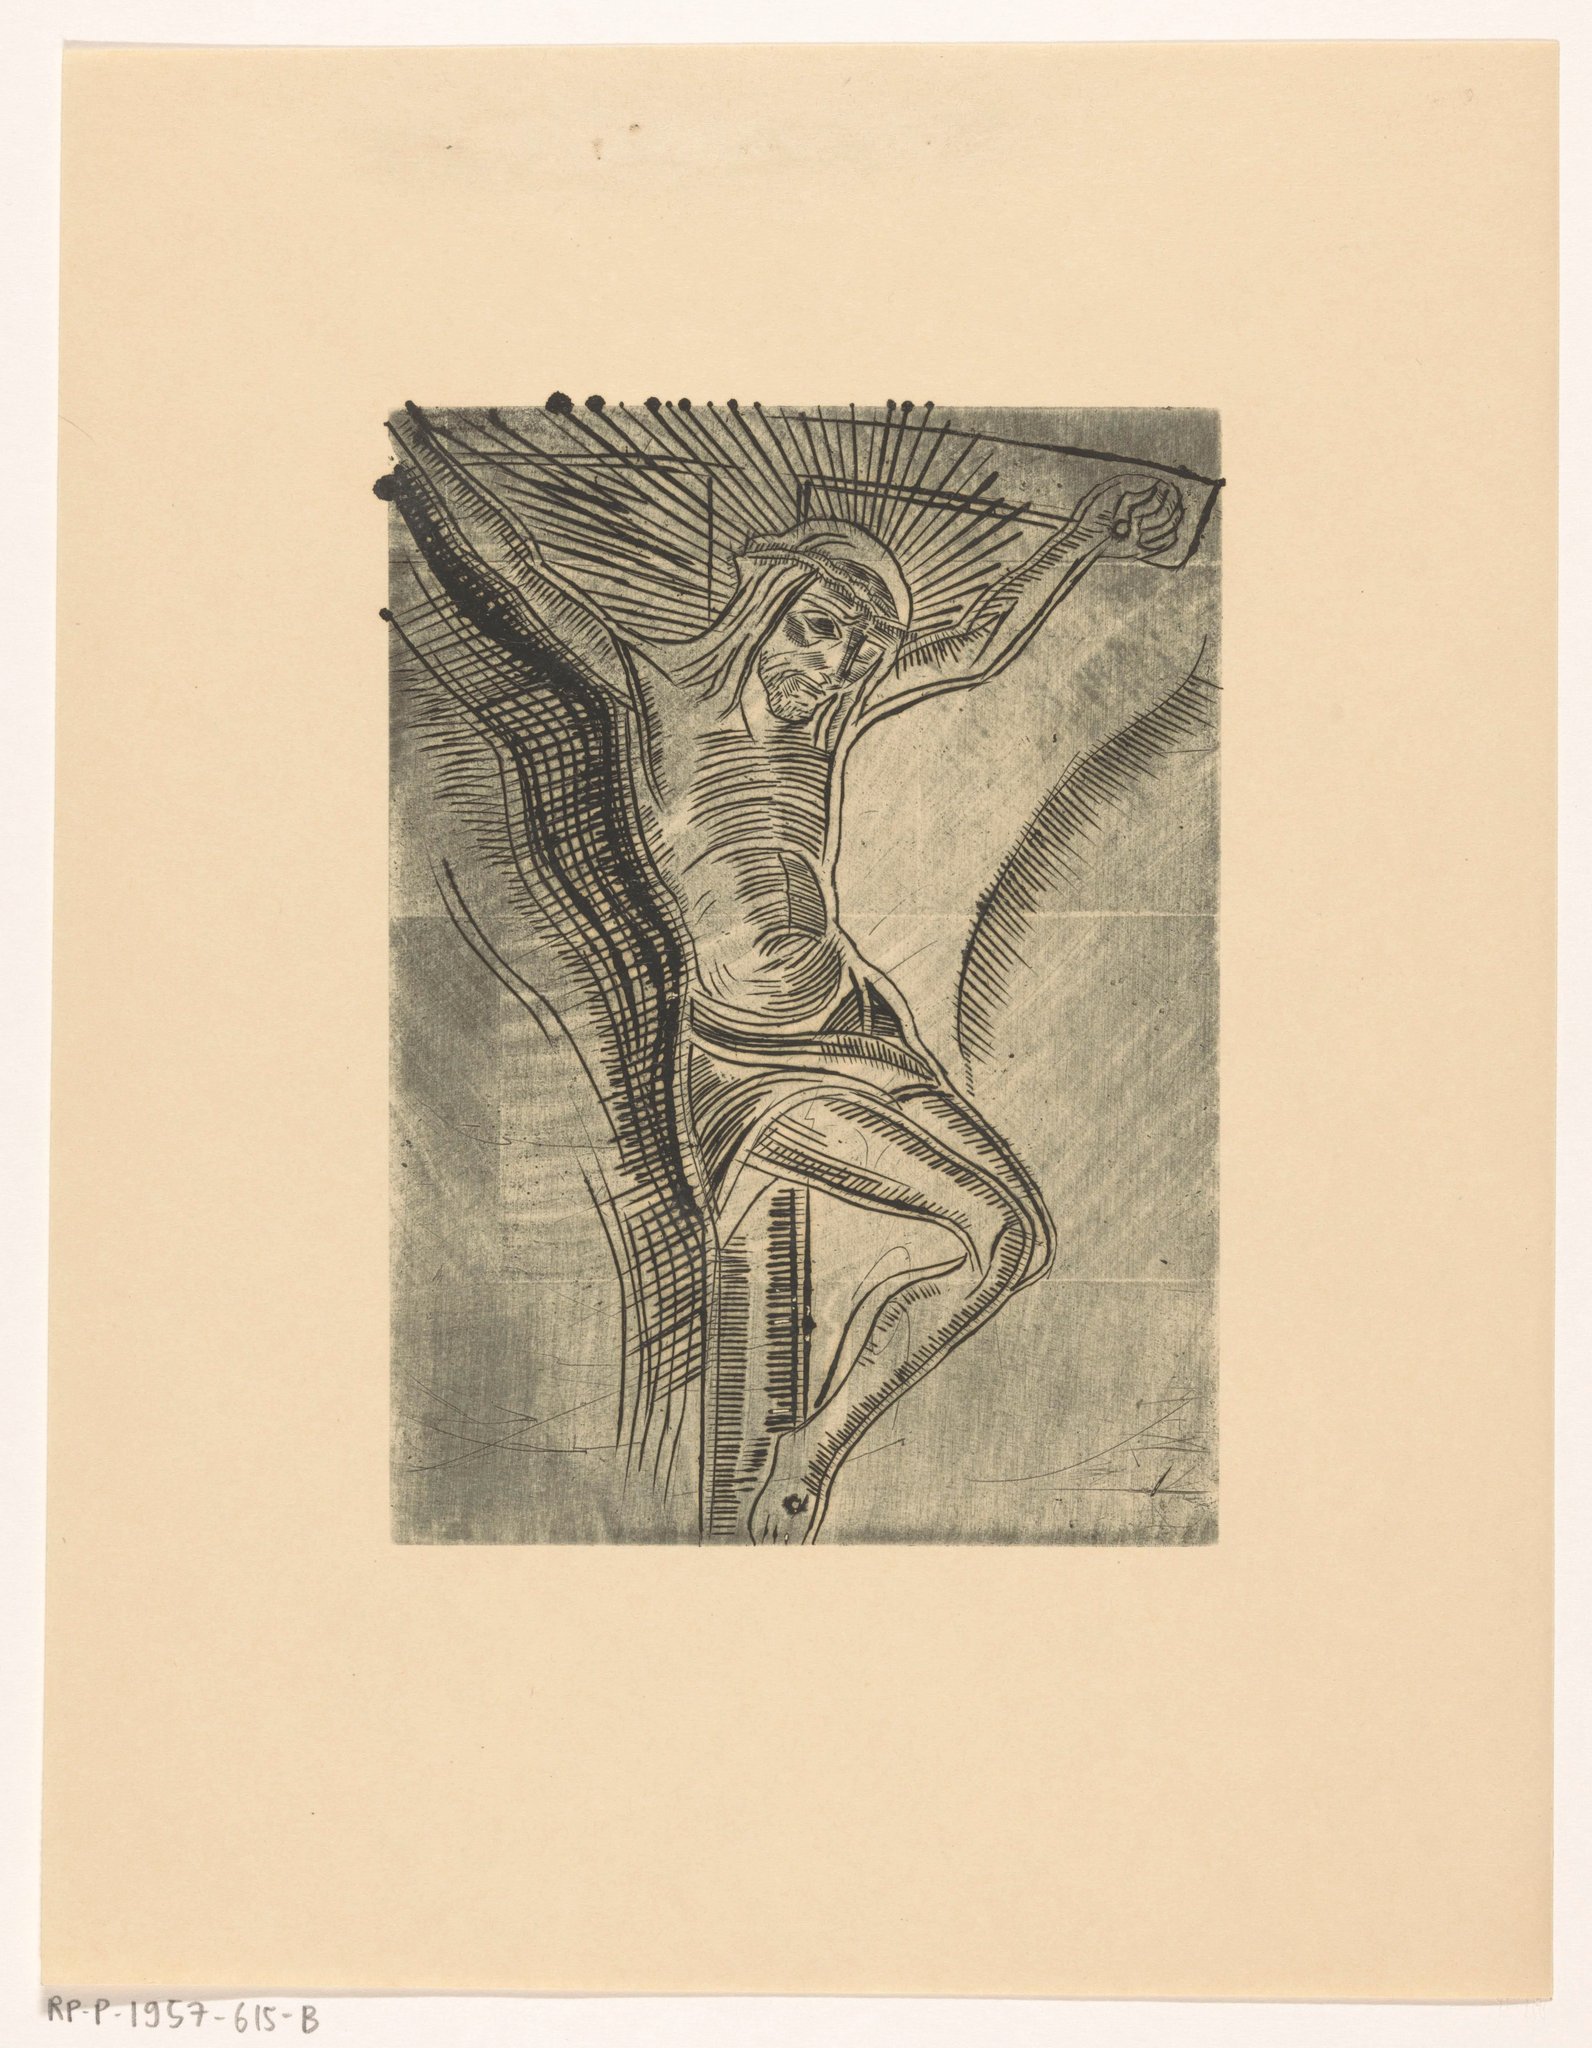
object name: print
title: Christus aan het kruis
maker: lodewijk schelfhout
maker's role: draughtsman, print maker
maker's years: 1881-1943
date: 1935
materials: paper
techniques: engraving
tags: specific types of crucified christ (in non-narrative context)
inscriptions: collector's mark: Lugt 2228